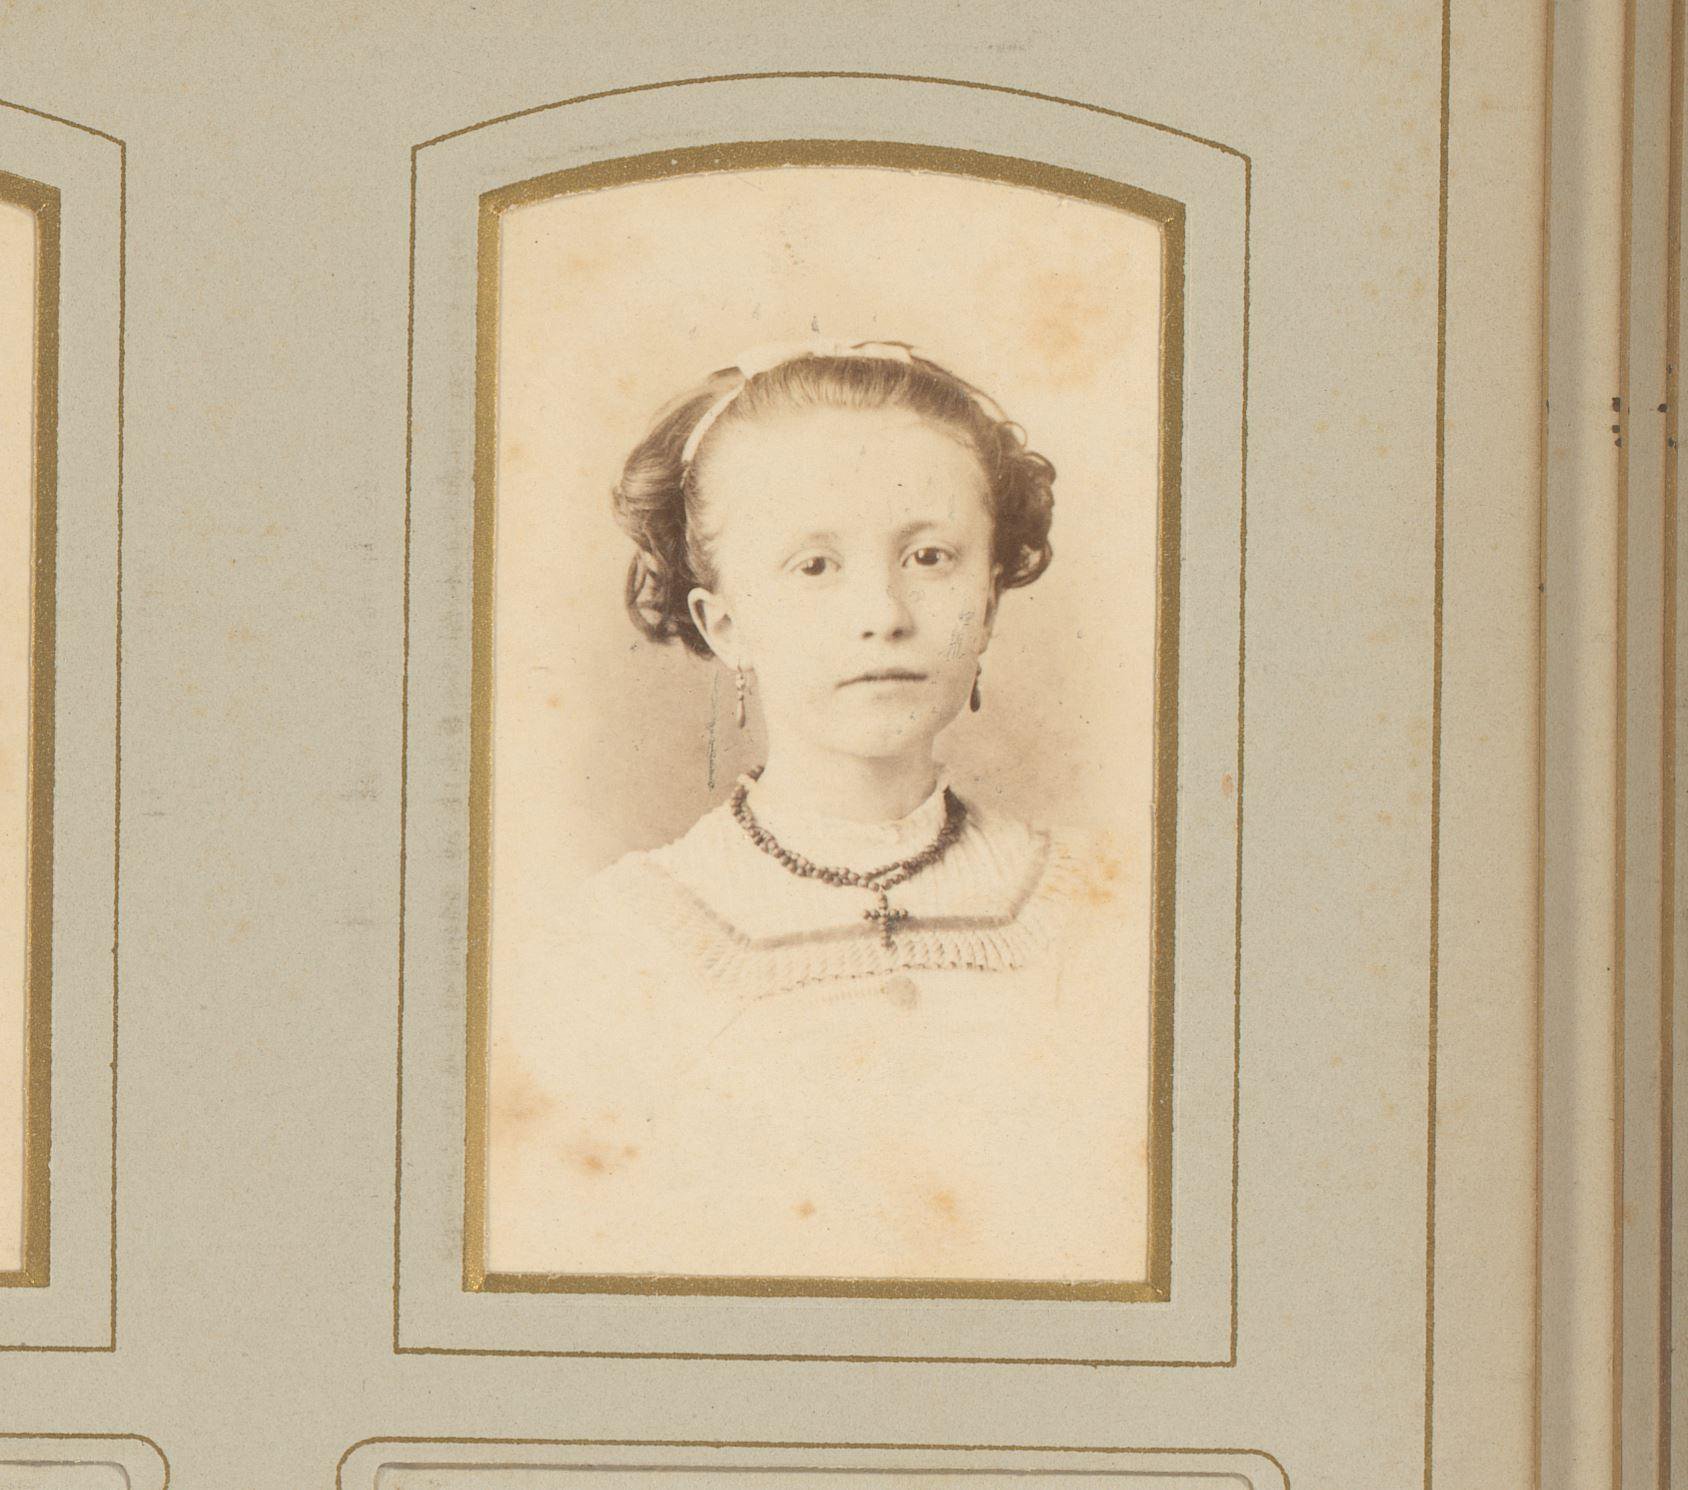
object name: album leaf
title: Portret van een meisje met halsketting met kruis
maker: palmer descamps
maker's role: goldsmith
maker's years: 1840-1884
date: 1865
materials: cardboard, photographic support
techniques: albumen print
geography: kortrijk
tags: historical persons - bb - woman, the cross ~ symbols of christ, girl (child between toddler and youth), necklace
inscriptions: inscription: ‘COURTRAI/ RUE DE LA LYS, 13./ PHOTOGRAPHIE/ Descamps/ PALMER/ ORFÈVRERIE’